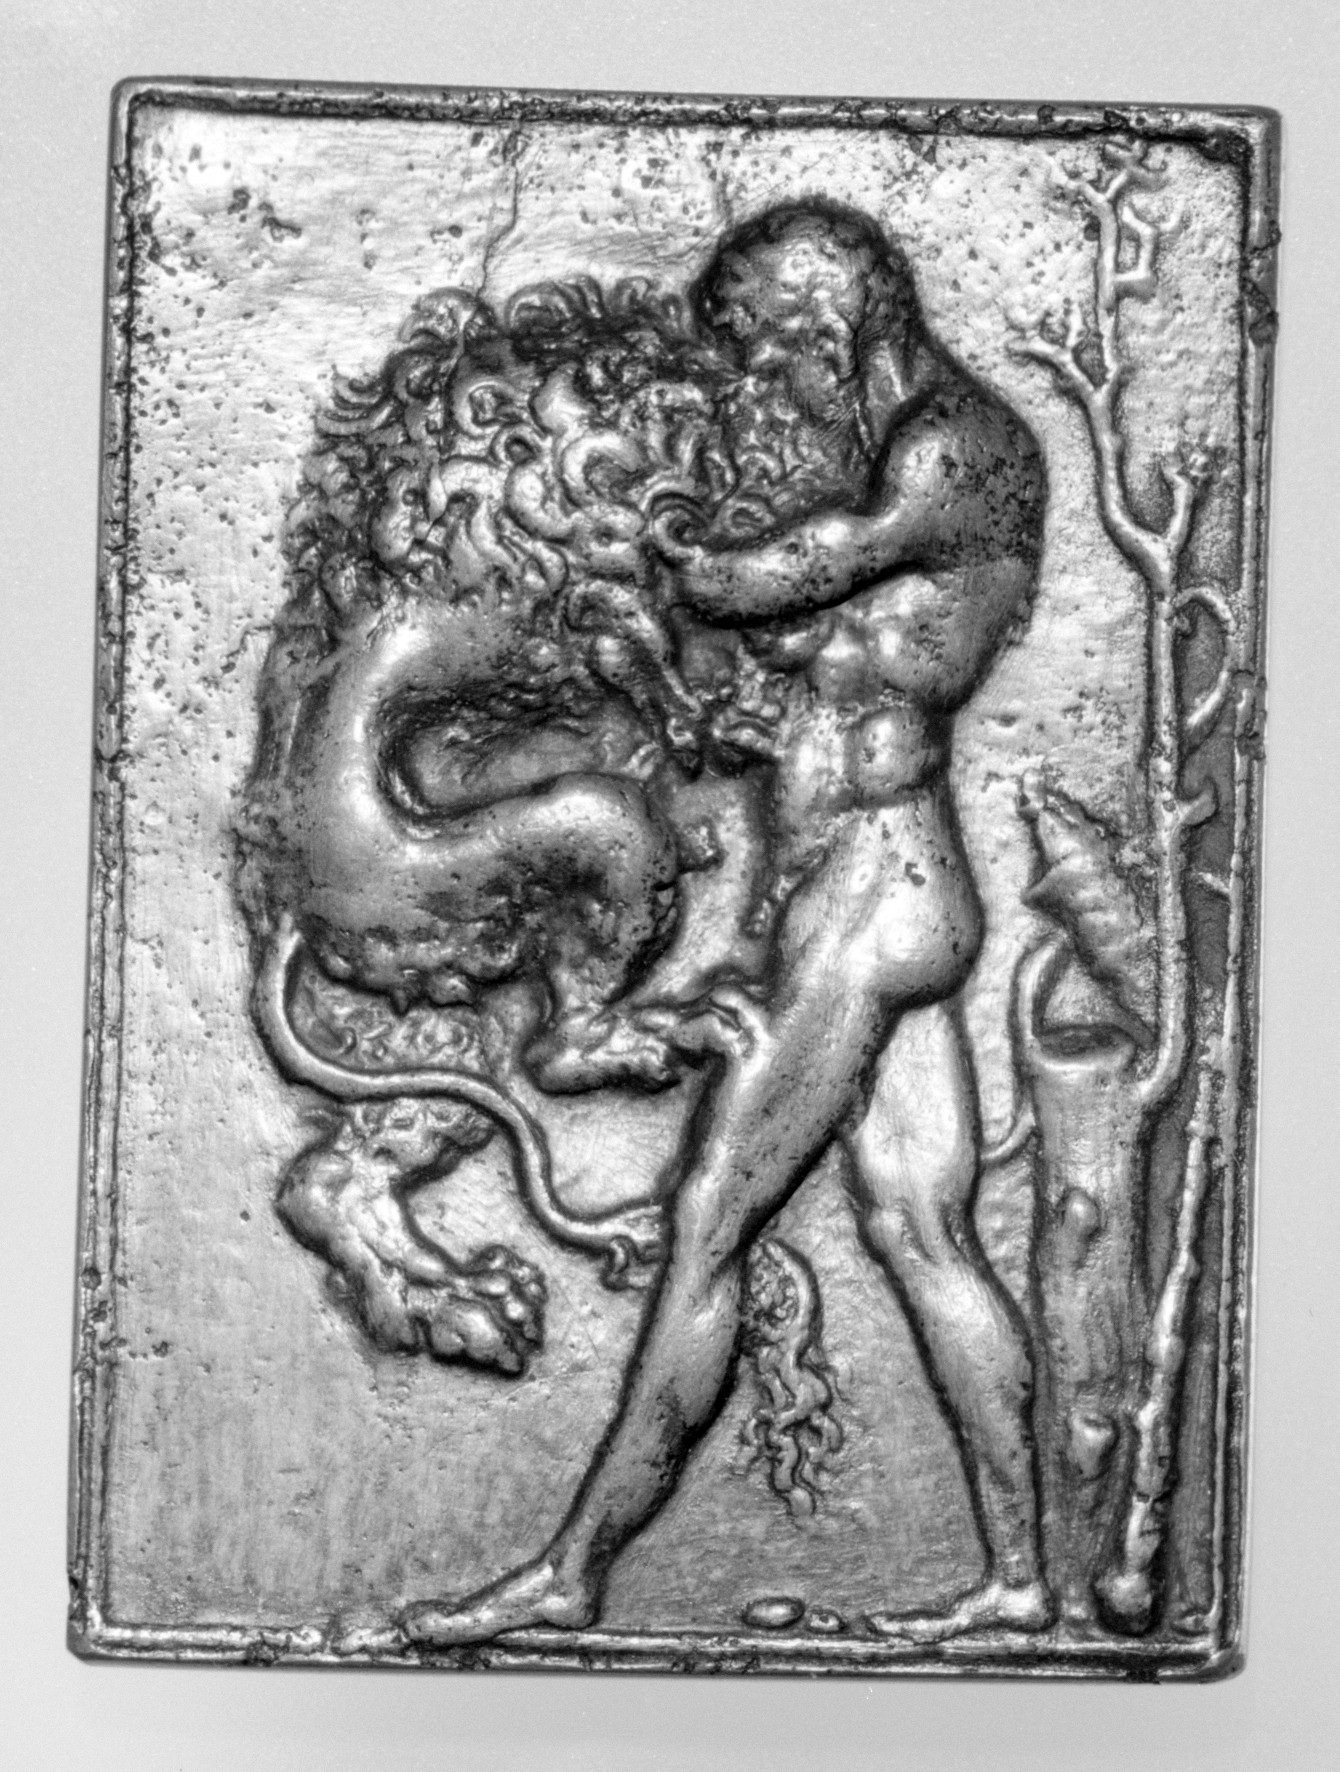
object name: plaquette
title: Hercules Strangling the Nemean Lion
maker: moderno (galeazzo mondella)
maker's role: artist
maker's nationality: italian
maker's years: 1467-1528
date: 1501-1533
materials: bronze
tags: hercules,lions